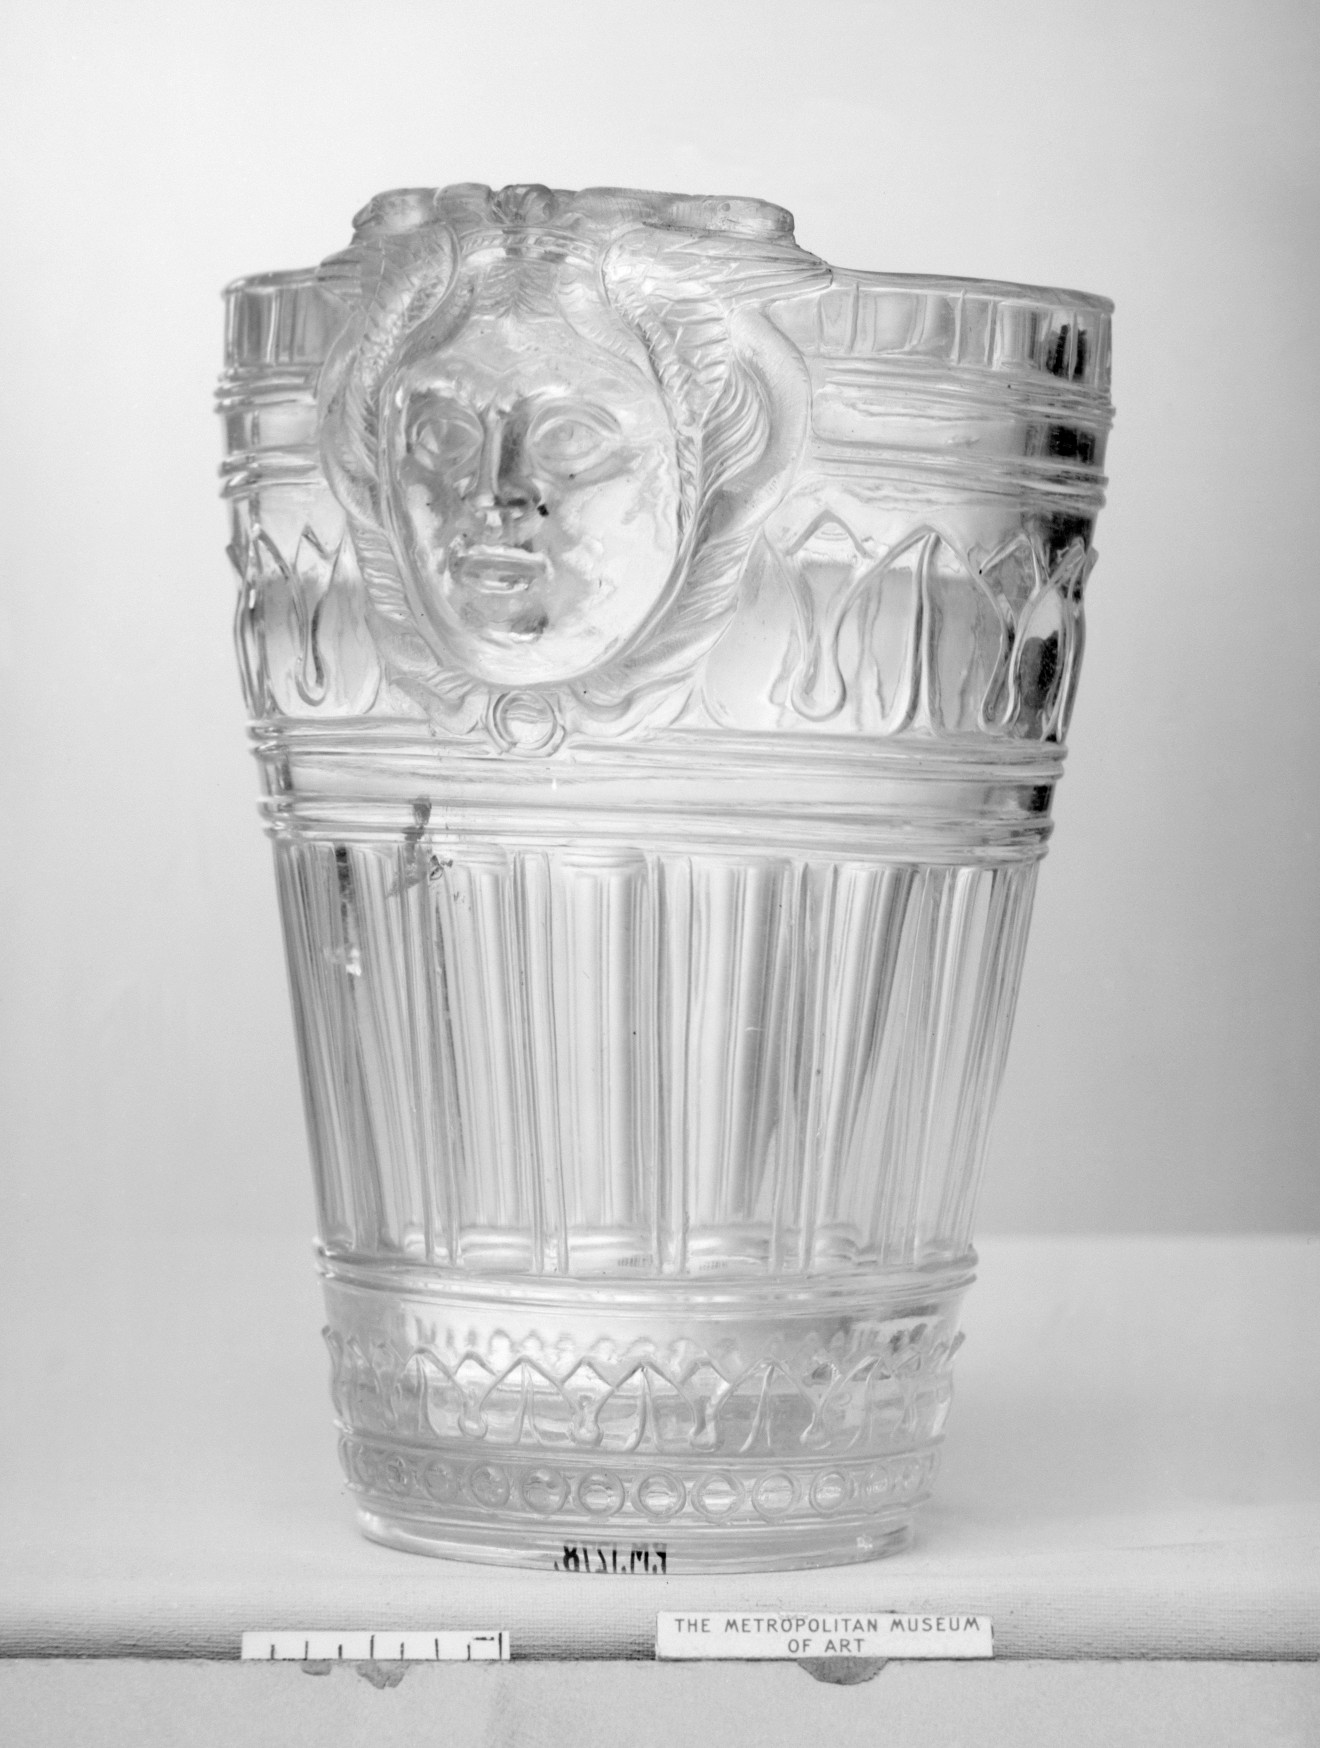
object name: drinking cup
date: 1501-1700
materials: quartz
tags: faces